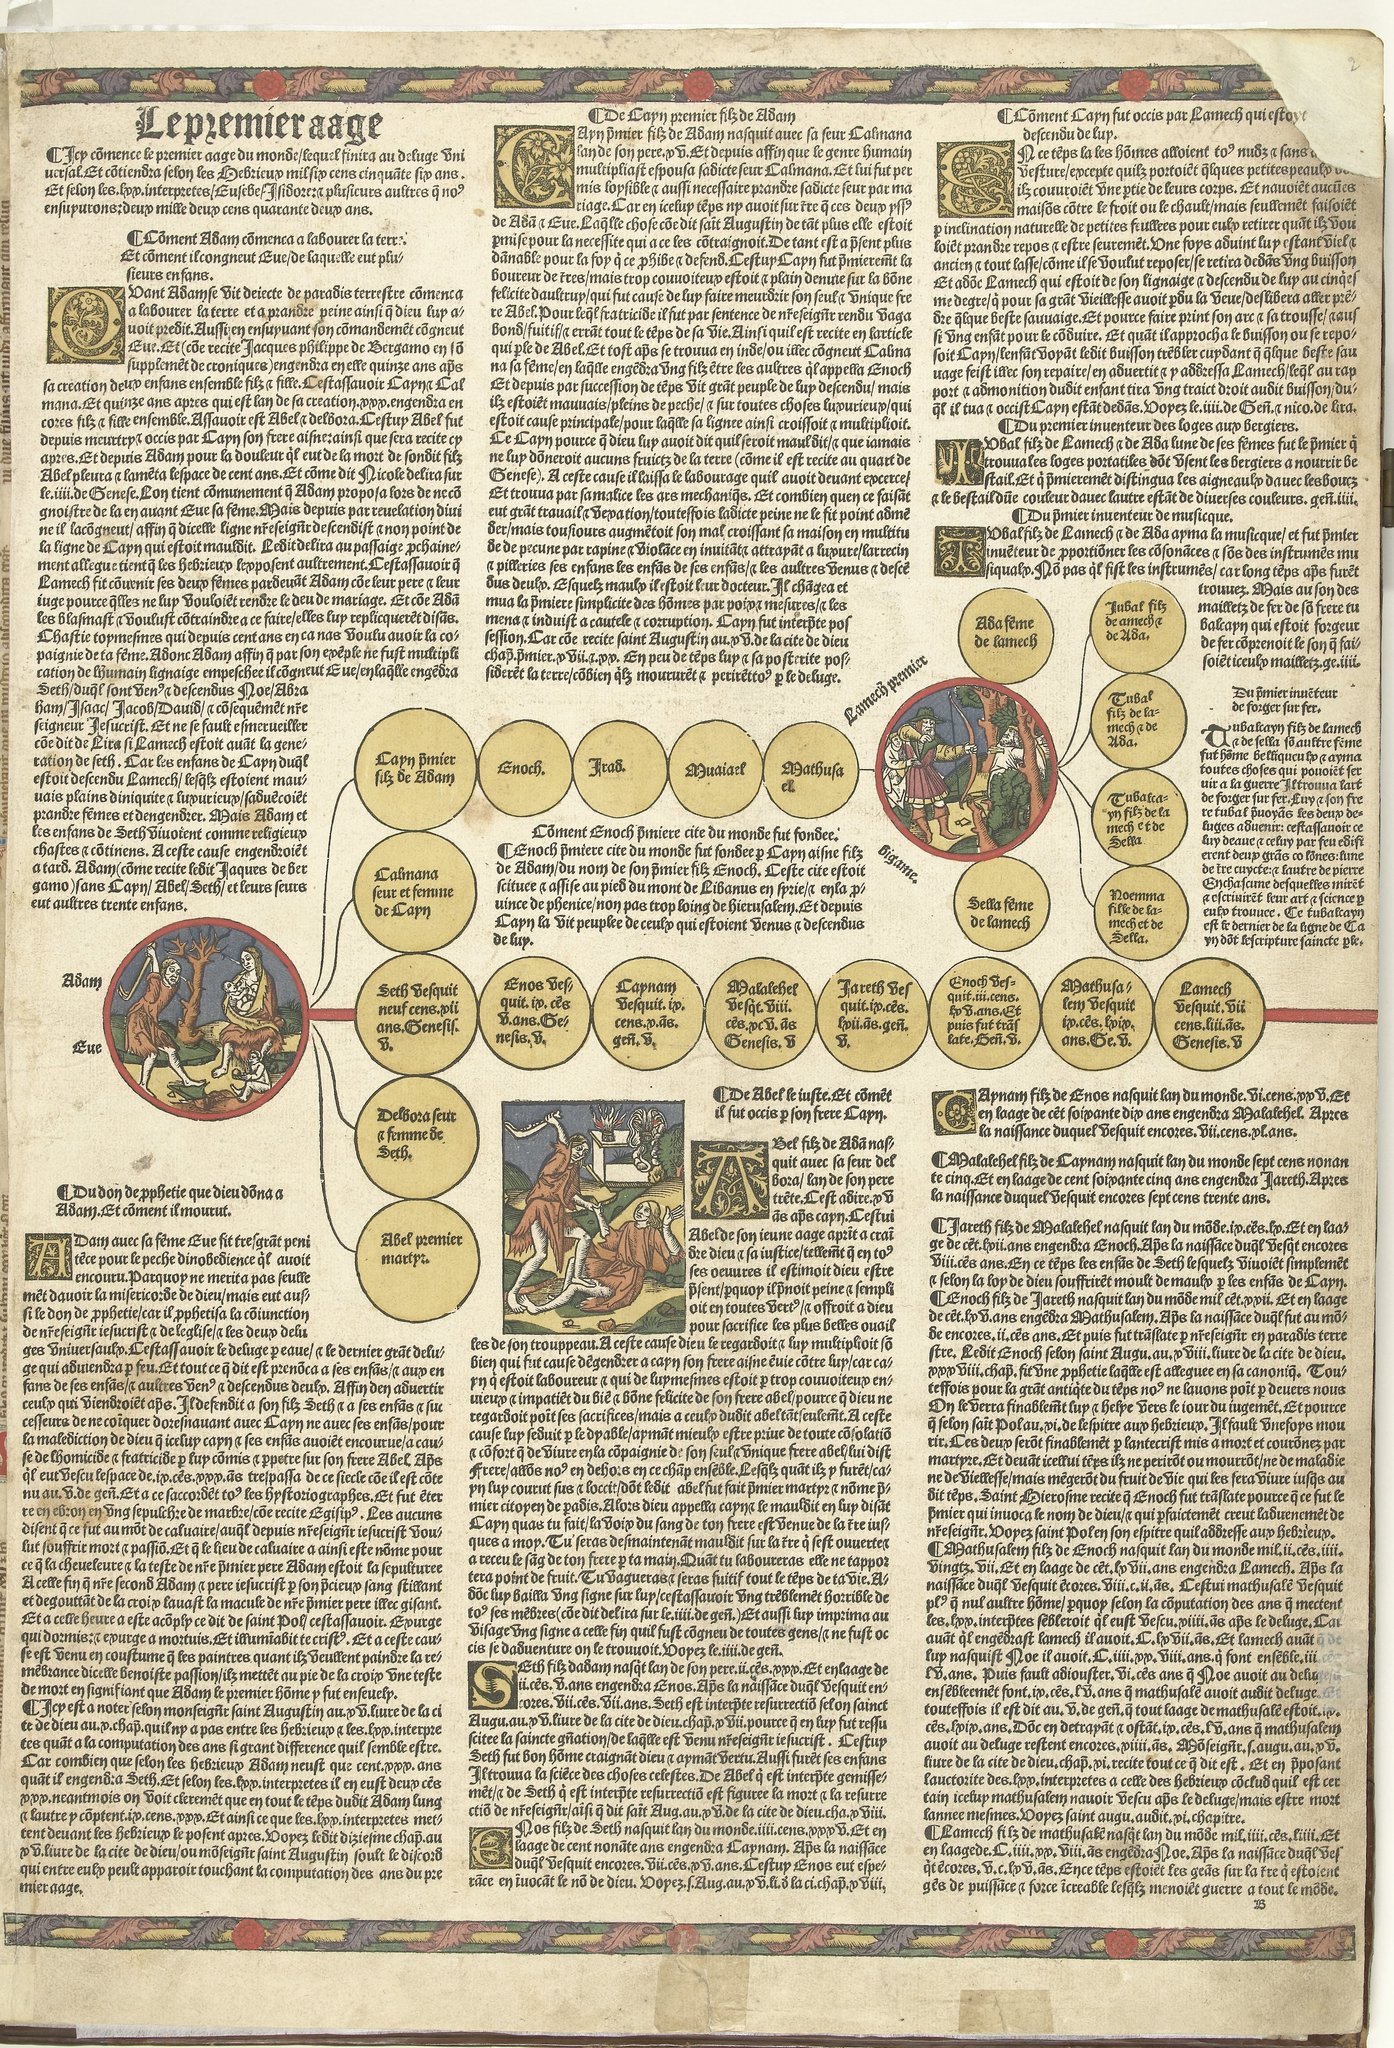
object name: print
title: Cronica Cronicarum (...), blad 2 recto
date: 1521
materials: paper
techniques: letterpress printing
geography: paris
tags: the killing of abel: cain slays him with a stone, a club or a jaw-bone, alternatively with a spade or another tool as weapon, the labours of adam and eve; infancy of cain and abel (genesis 4:1-2), lamech kills cain: cain is accidentally shot dead by an arrow of the blind lamech, who is assisted in the hunt by his son tubalcain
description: Blad 2 recto van een wereldkroniek. Tekst in boekdruk in het Frans in drie kolommen met versierde initialen. Linksboven de titel: Le premier aage. Rechts een ronde voorstelling van Adam en Eva buiten het paradijs. Adam bewerkt de grond en Eva verzorgt hun kinderen Kaïn en Abel. In het midden een voorstelling van Kaïn die zijn broer Abel vermoordt. Links een ronde voorstelling van Kaïns nakomeling Lamech, die blind is en per ongeluk met pijl en boog Kaïn neerschiet. De ronde voorstellingen zijn met elkaar verbonden en vormen met andere cirkels die gevuld zijn met namen een schematische weergave van genealogie en vorstenopvolging, die zich uitstrekt over meerdere bladzijden van de kroniek.